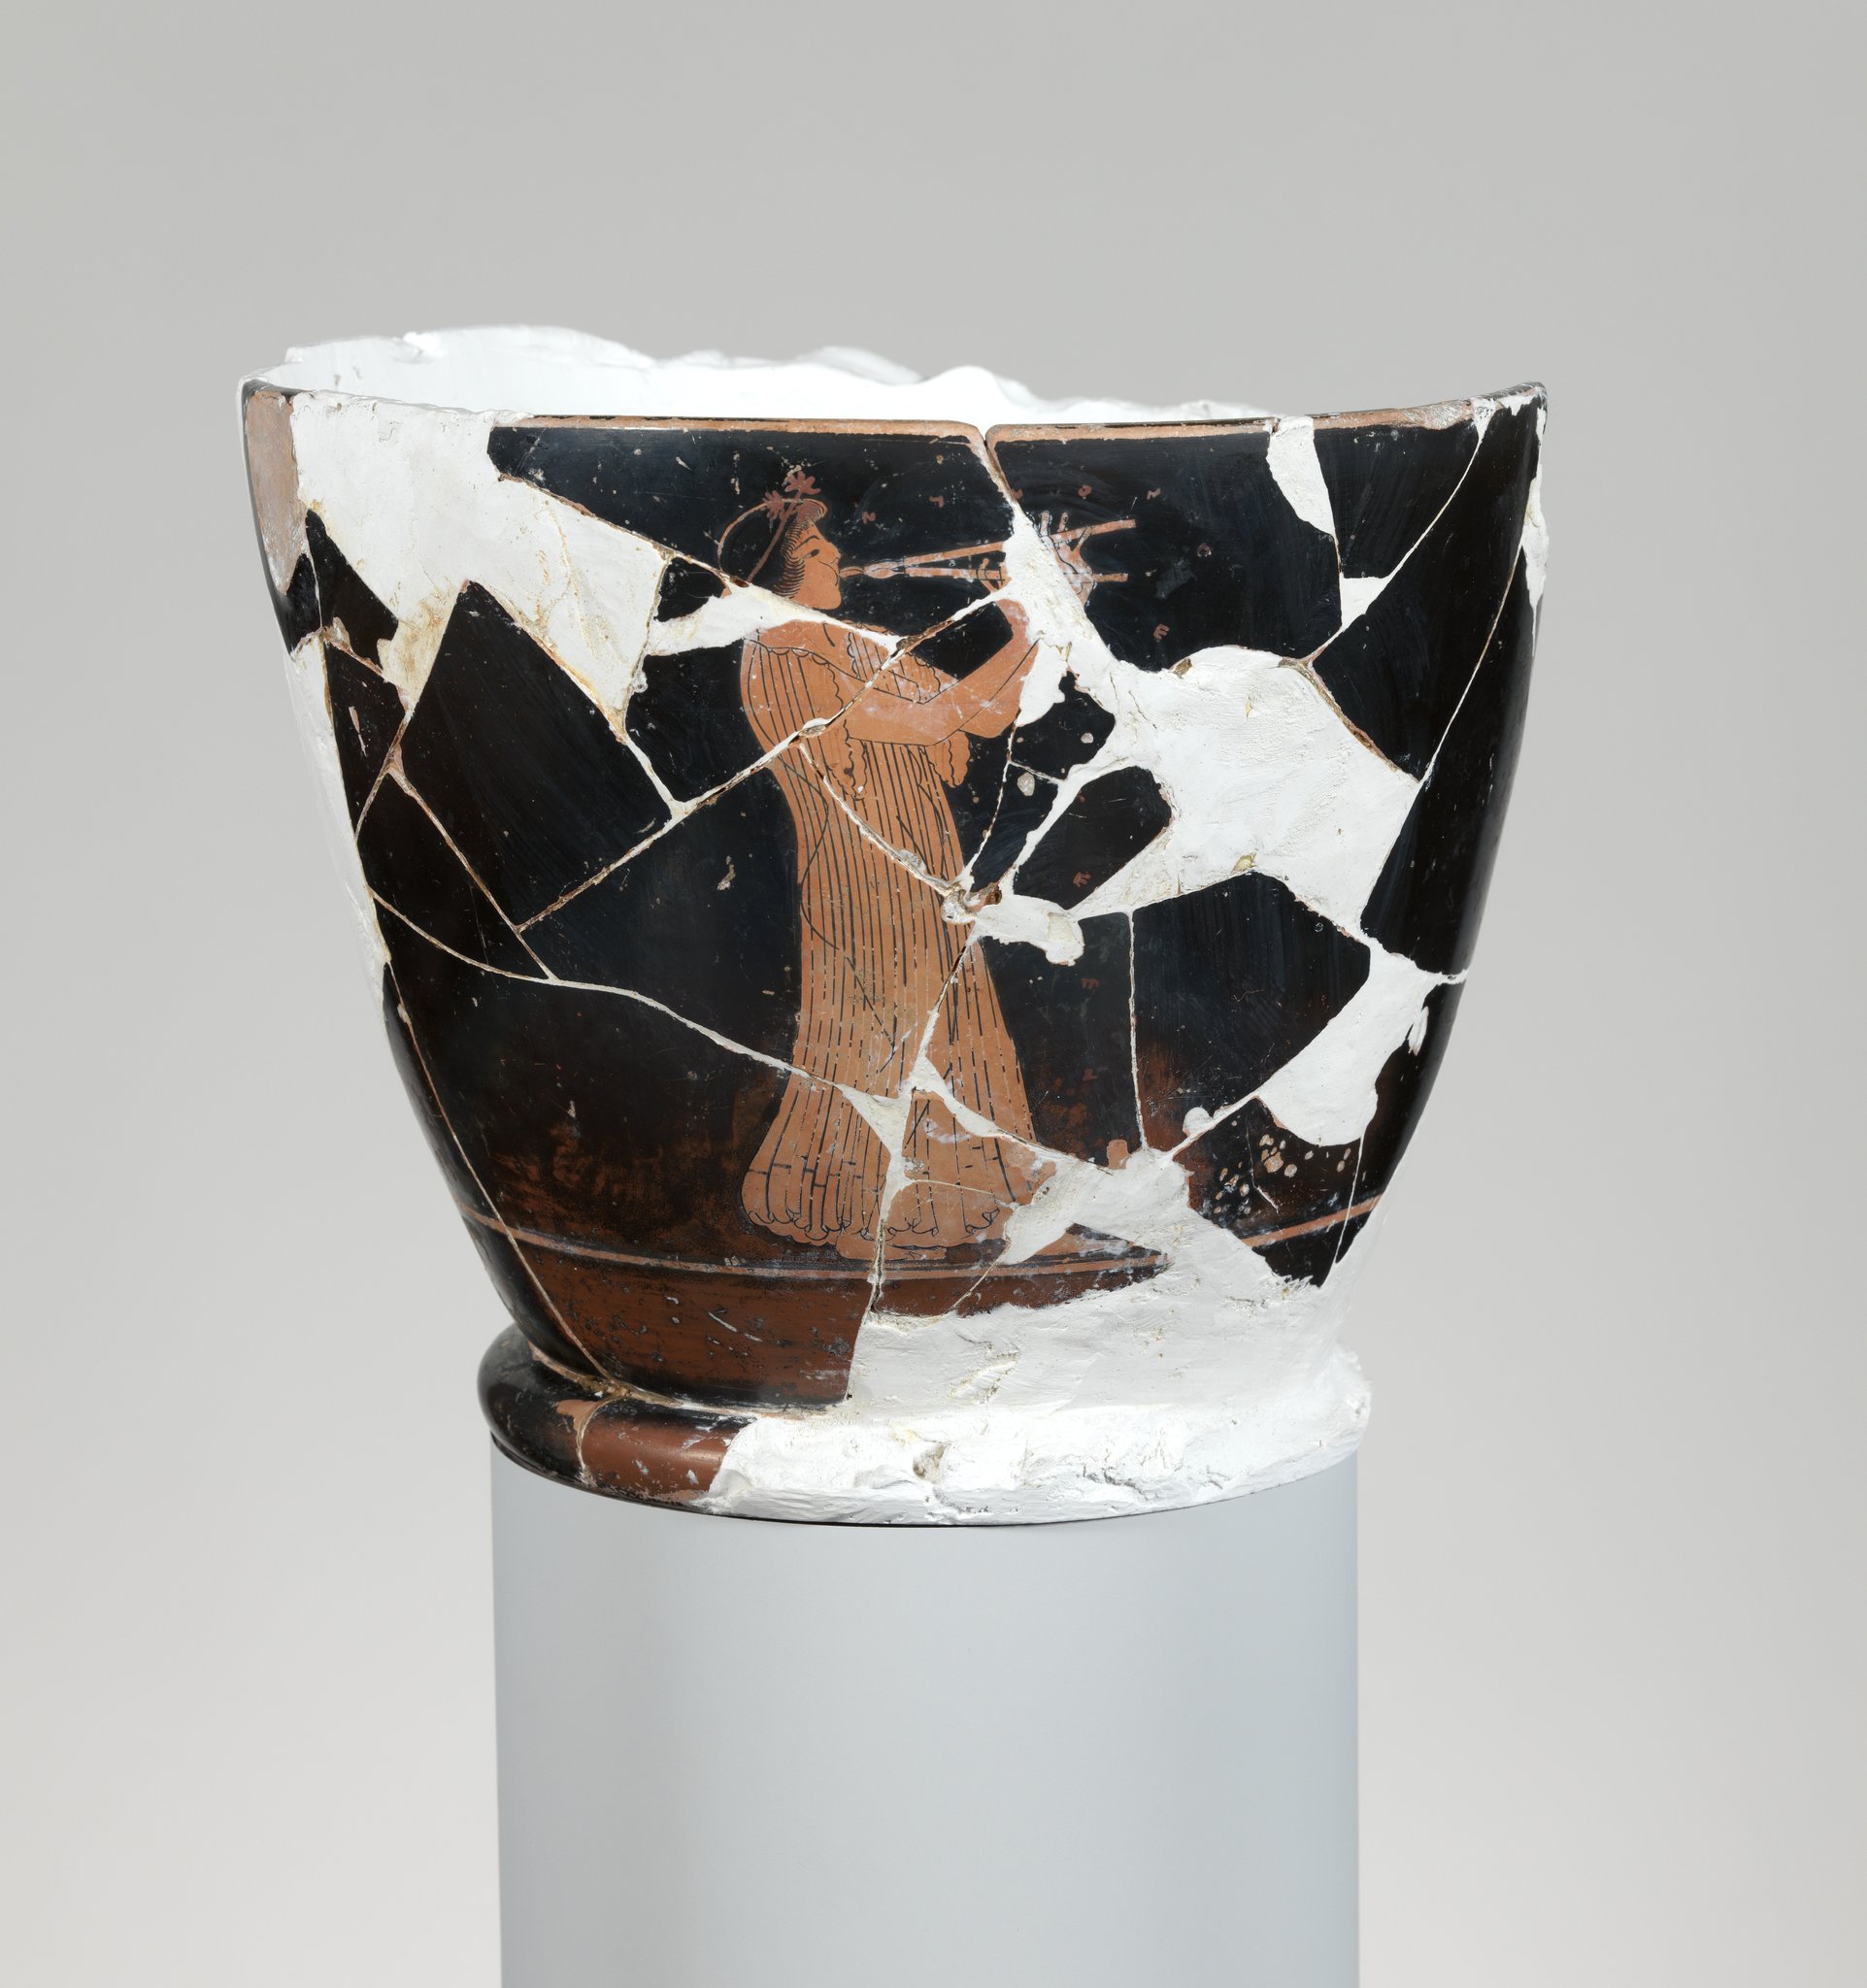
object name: skyphos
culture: greek, attic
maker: brygos painter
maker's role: artist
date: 490-480 BCE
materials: terracotta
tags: human figures,musical instruments